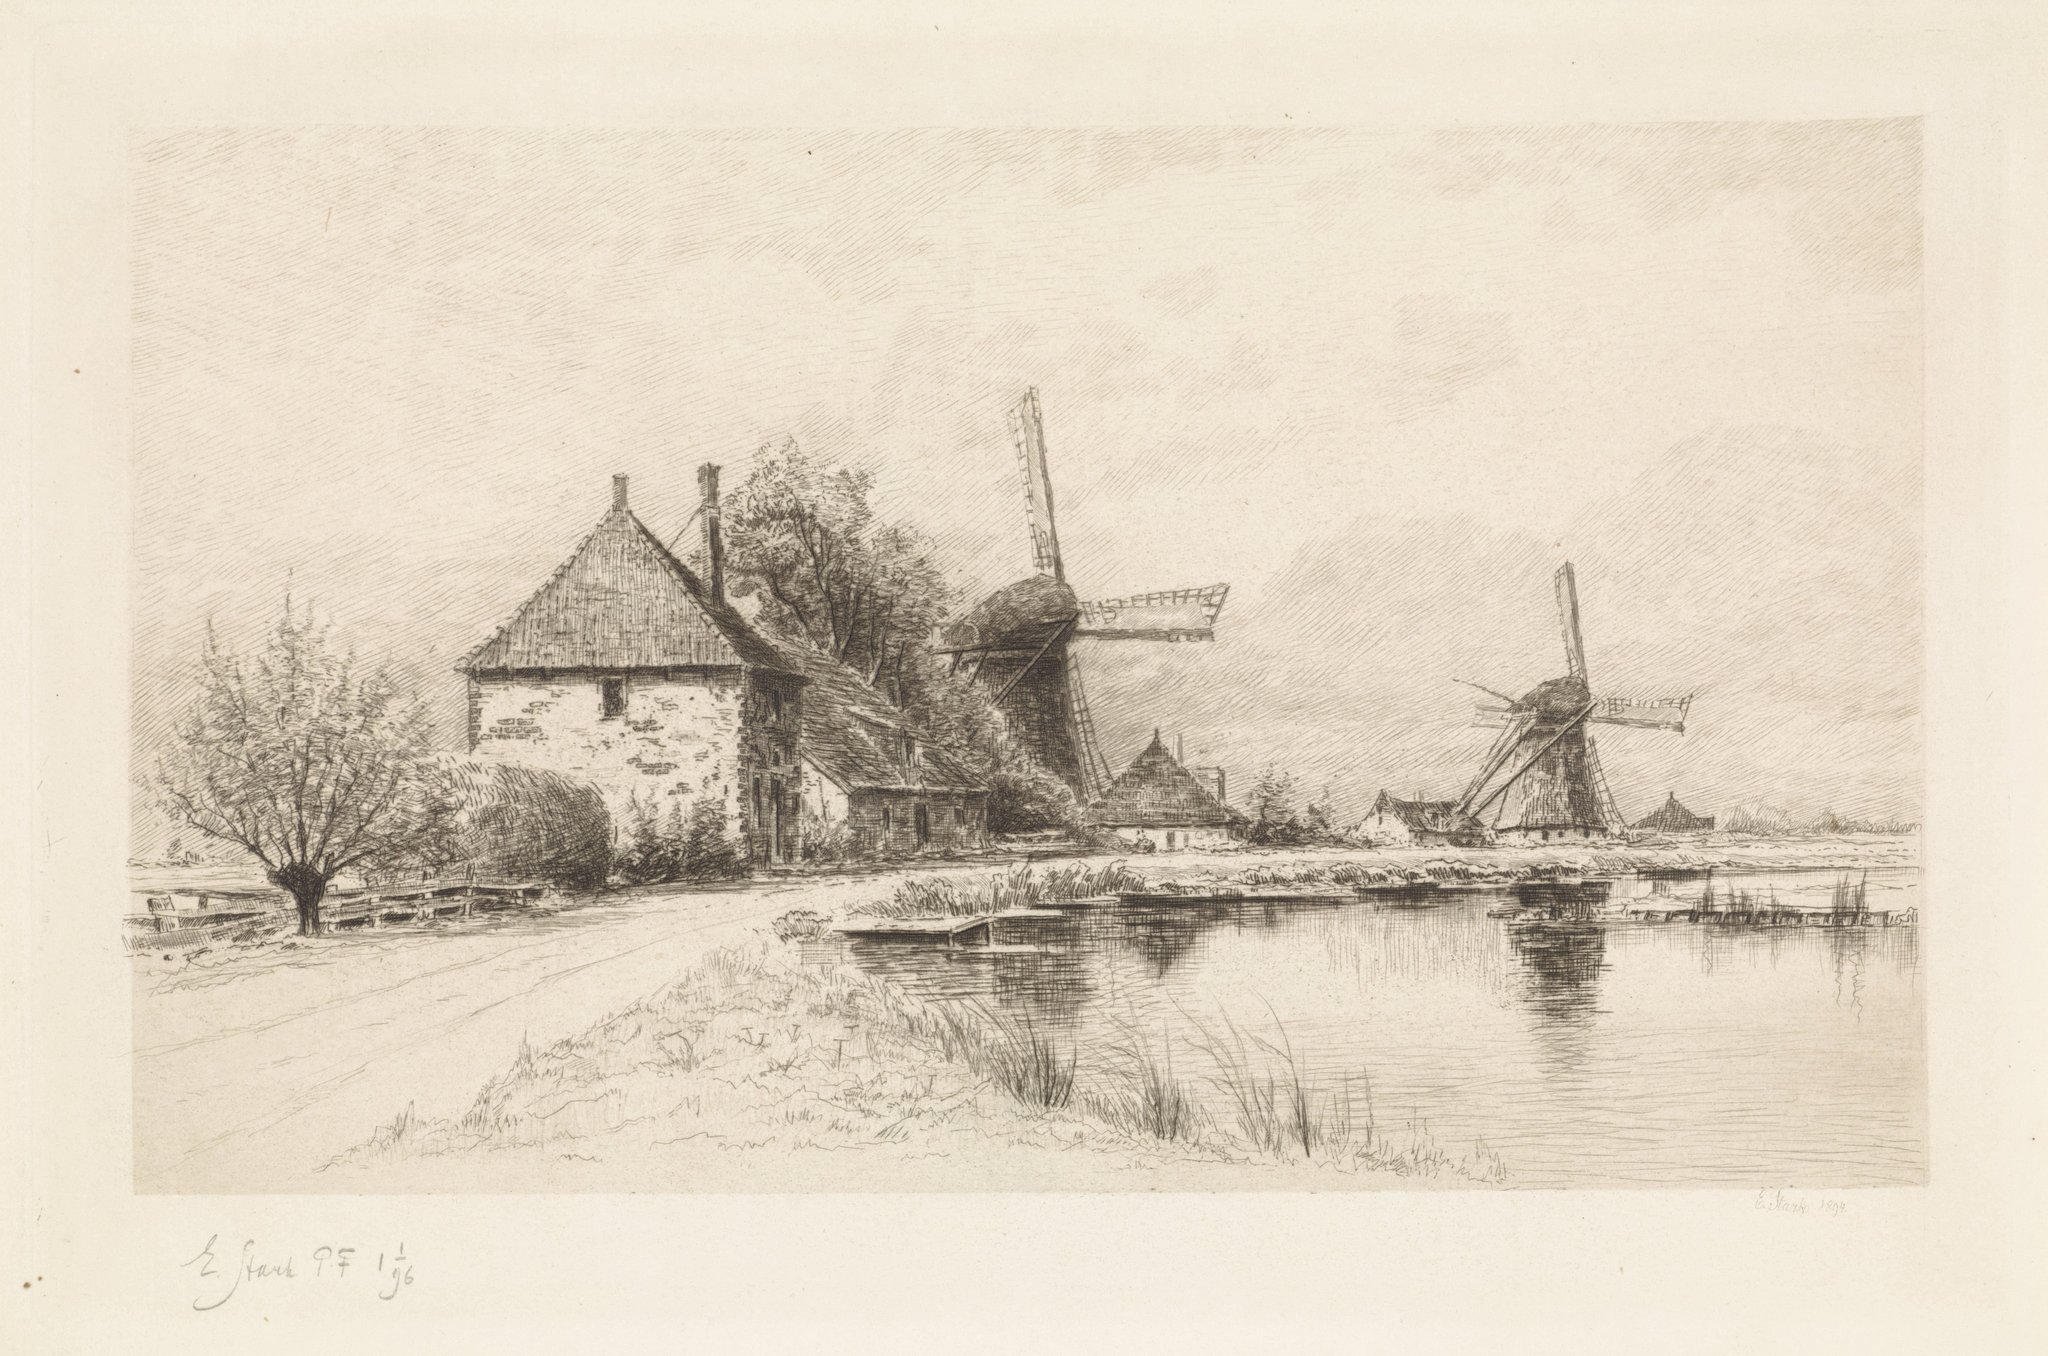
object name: print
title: Huizen en twee molens langs een rivier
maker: elias stark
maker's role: draughtsman, print maker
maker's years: 1849-1933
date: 1894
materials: paper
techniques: etching, intaglio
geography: nieuwer-amstel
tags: river, windmill in landscape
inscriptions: collector's mark: Lugt 2228, inscription: ‘E. Stark P.F. 1 1/96’